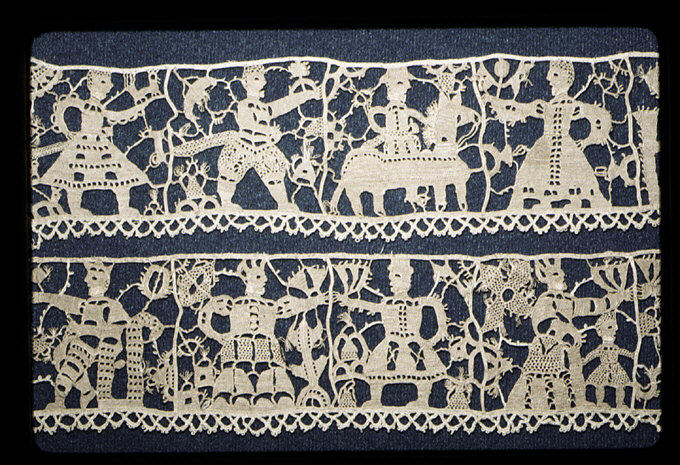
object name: border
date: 1567-1600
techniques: lace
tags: human figures,horses